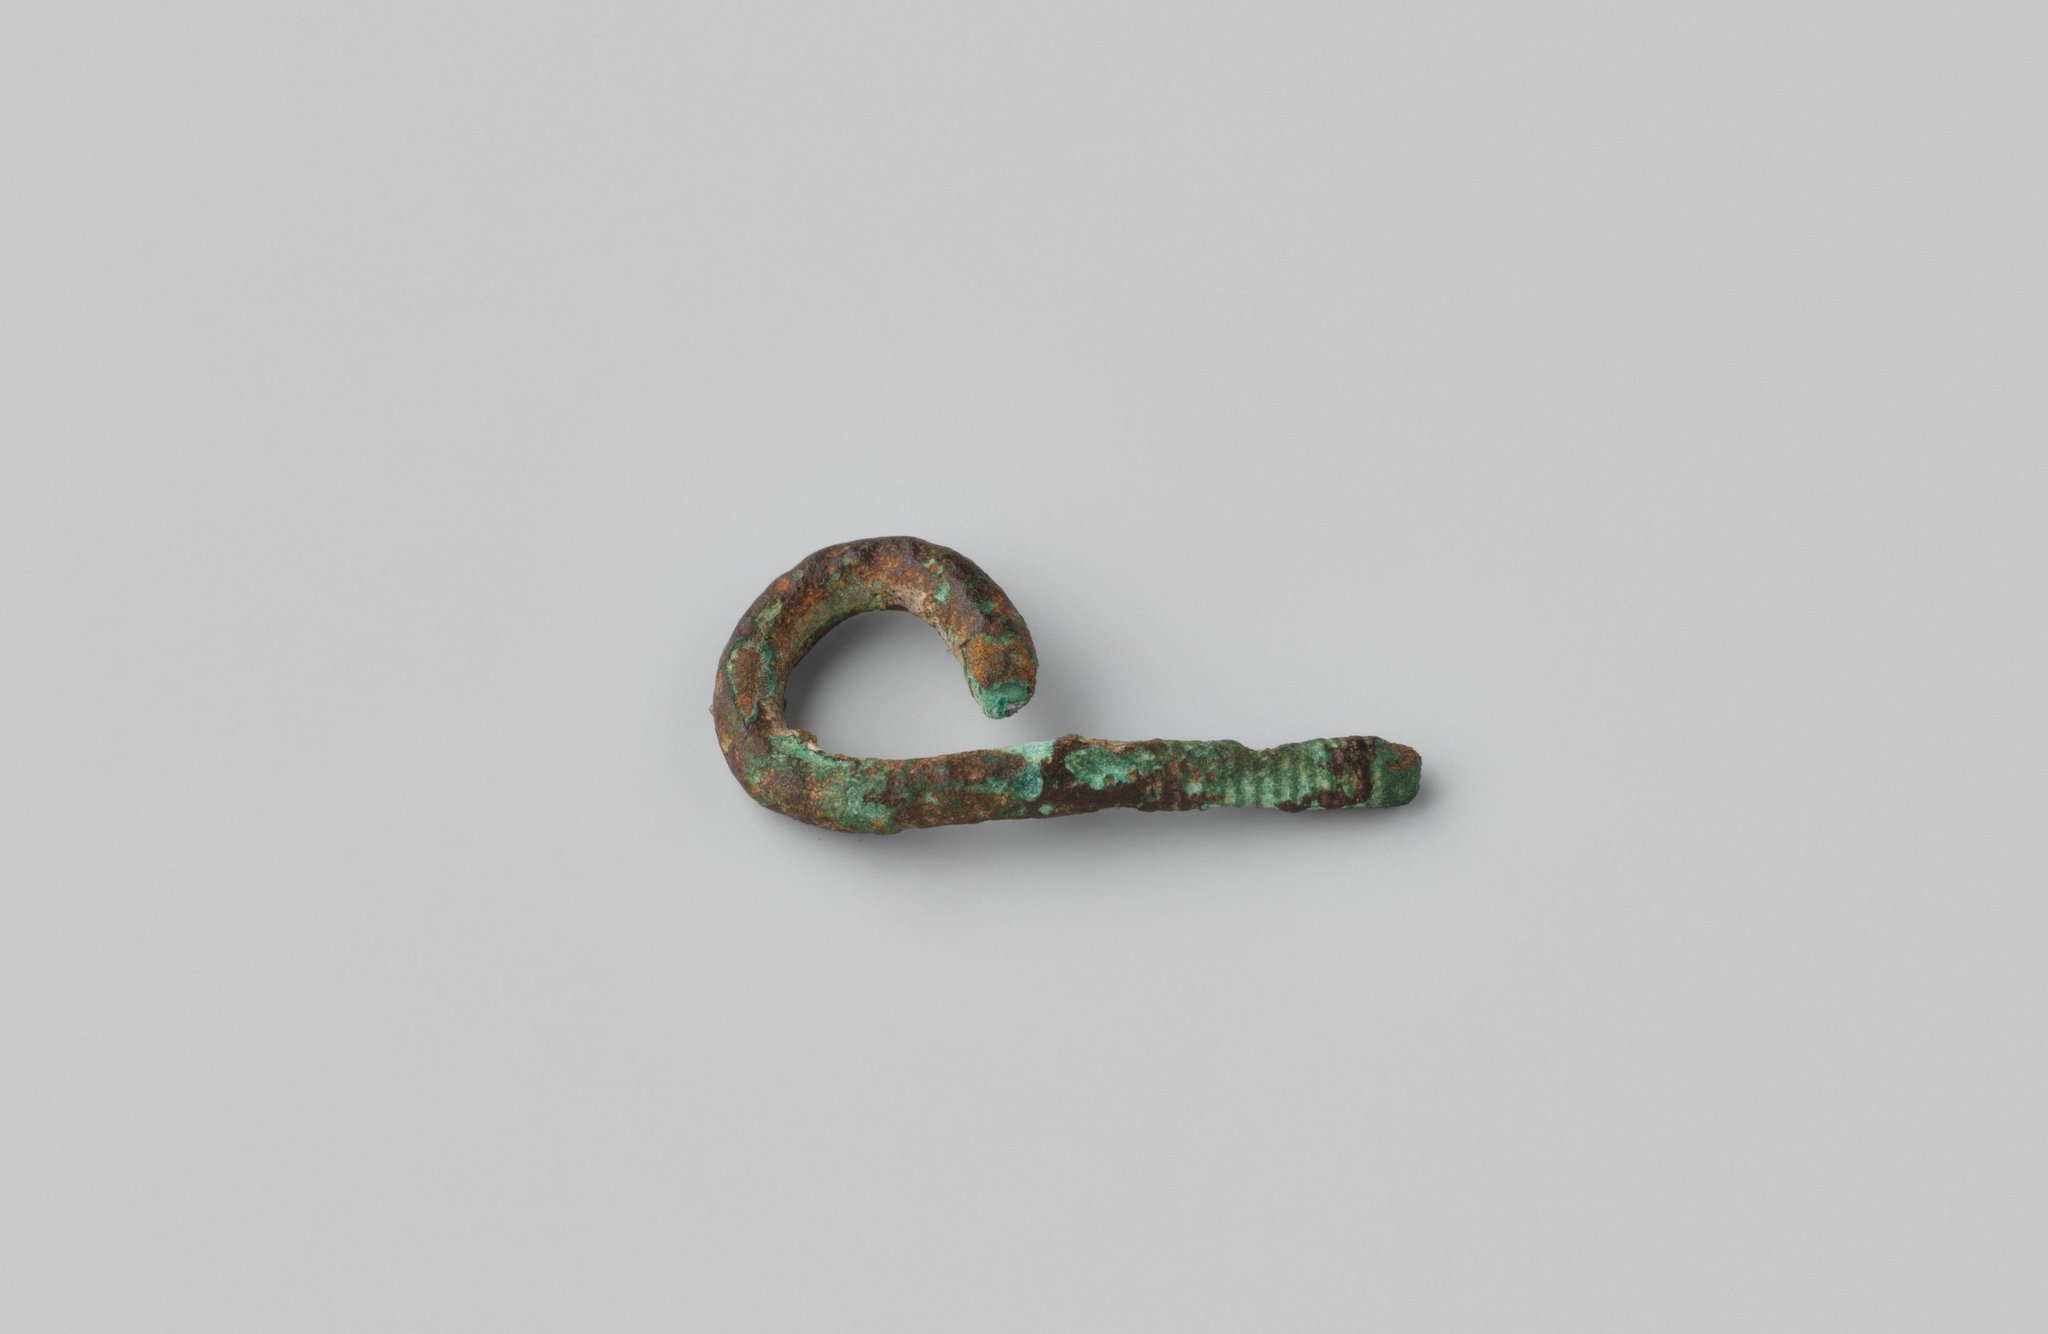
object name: screw eye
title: Schroefoog afkomstig uit het wrak van de Oost-Indiëvaarder Hollandia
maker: Anonymous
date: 1700-1743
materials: copper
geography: netherlands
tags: verenigde oostindische compagnie, hollandia (schip)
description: Screw eyes; (1) (2.3l), oval eye of looped wire (1.1d, 0.2d) with threaded end.